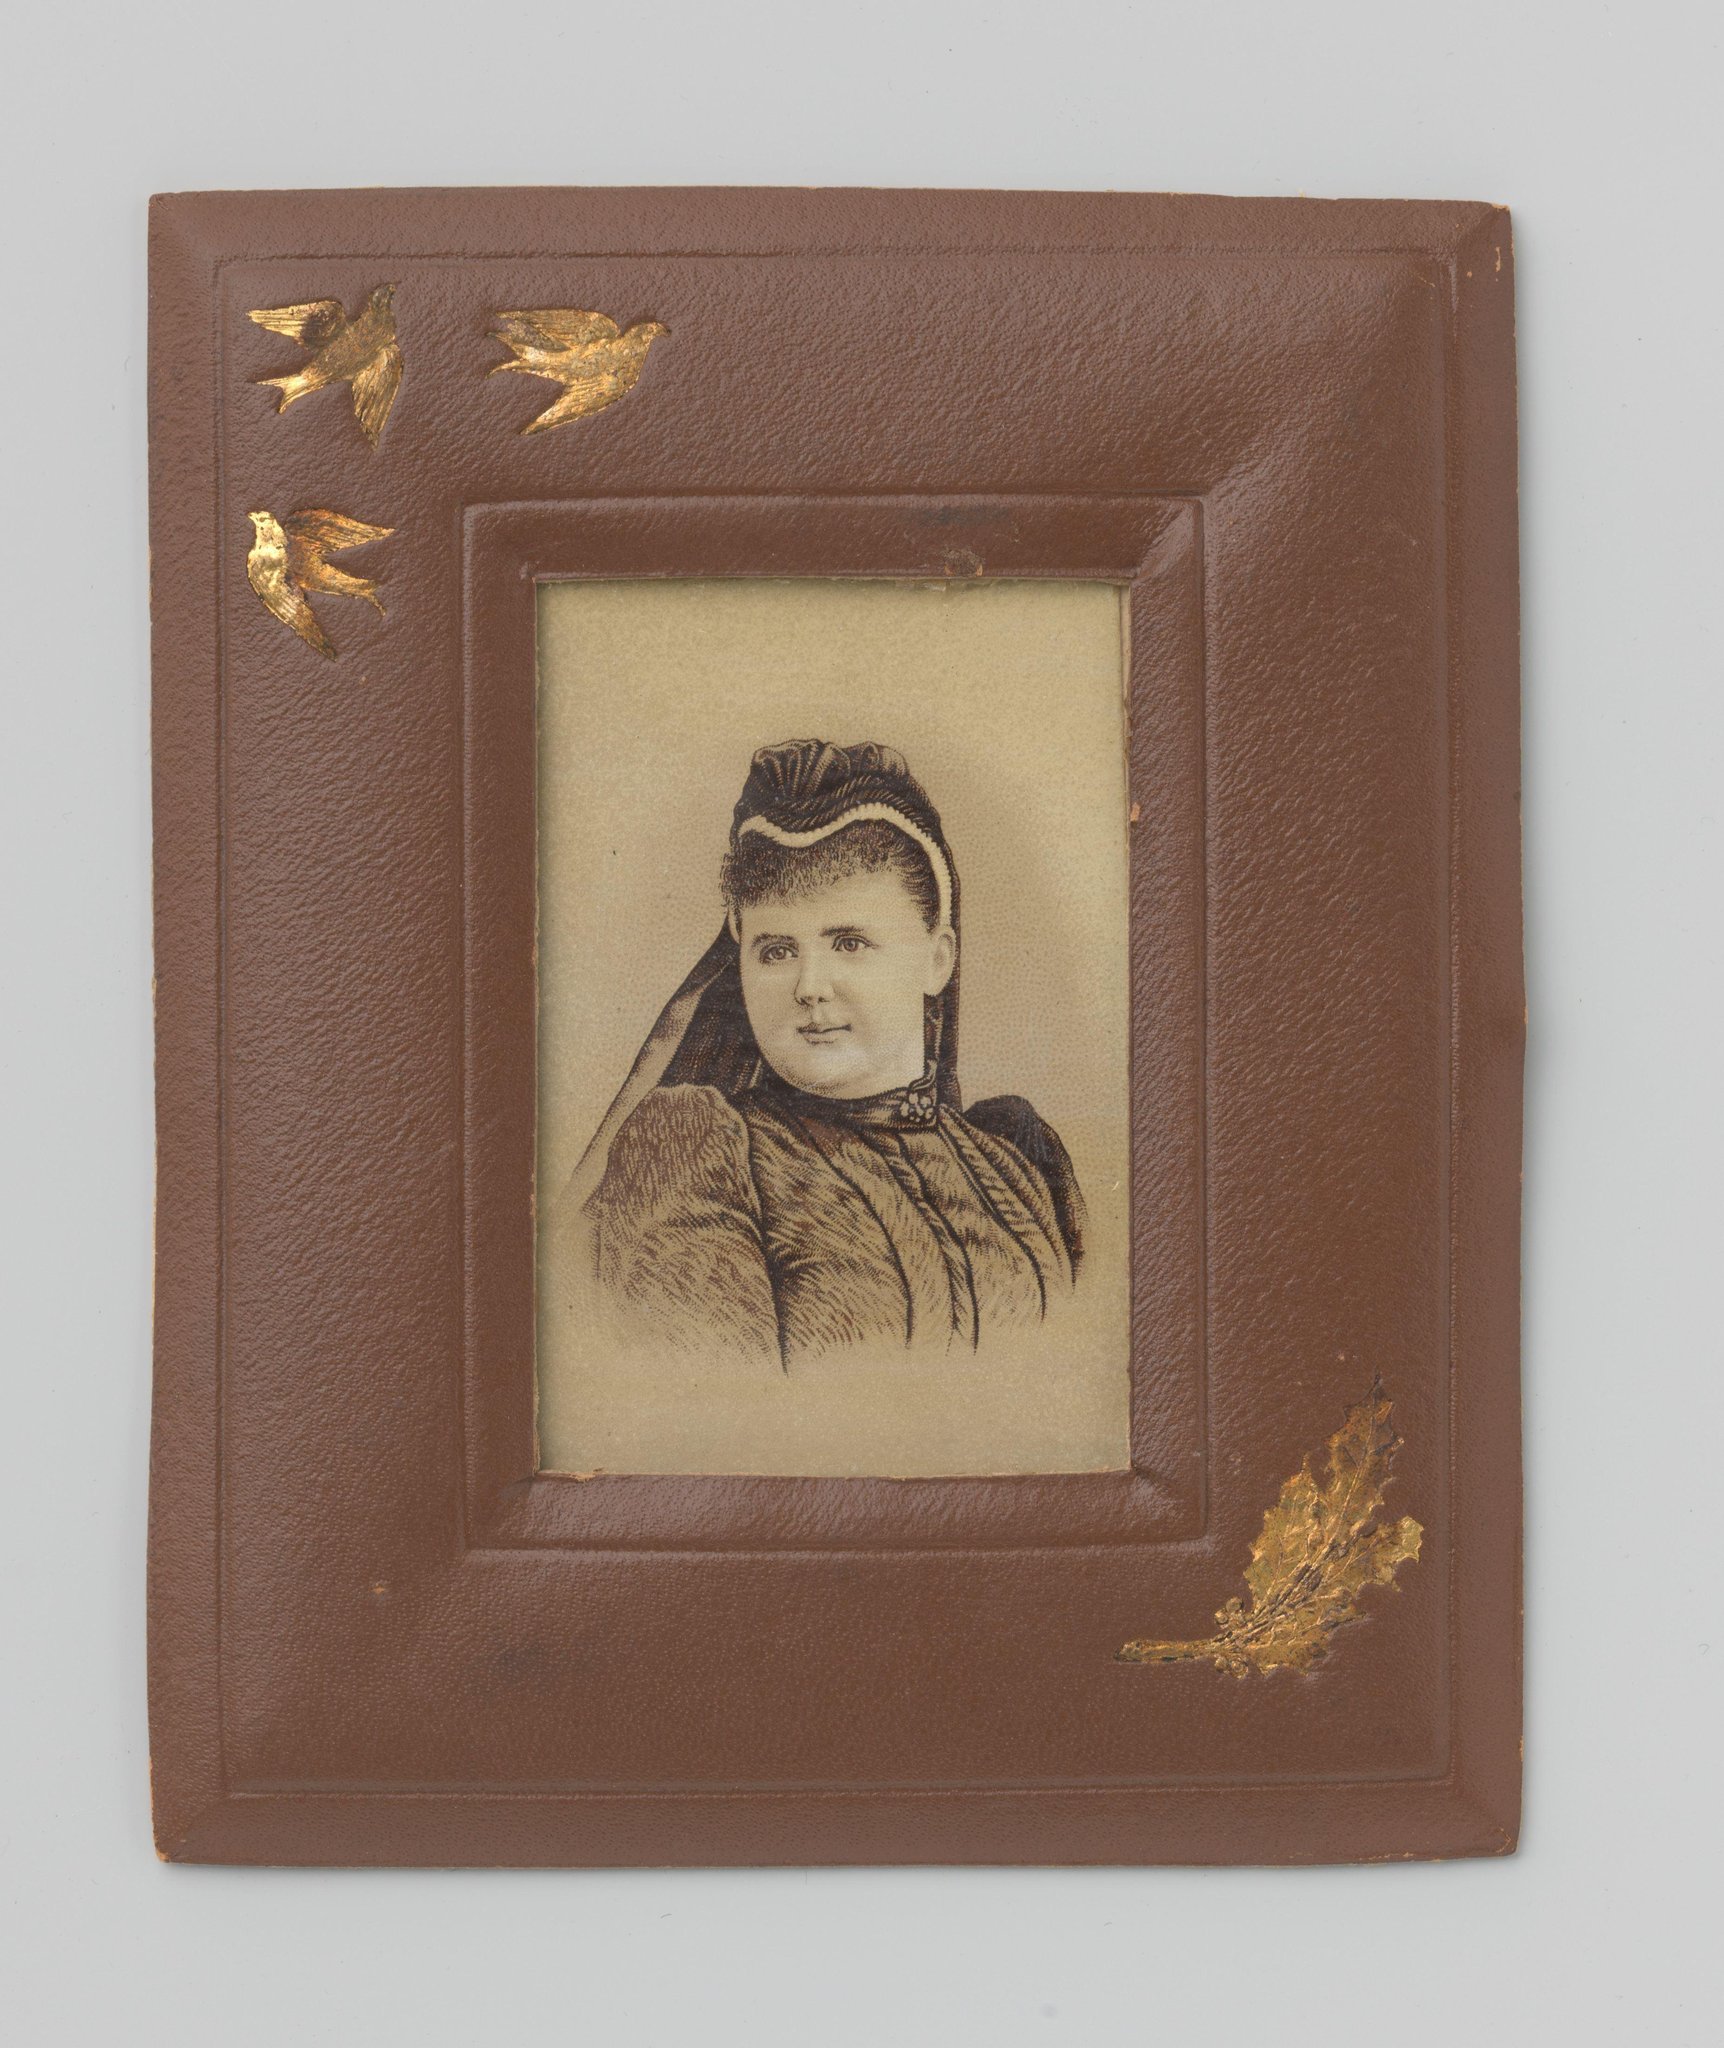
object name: print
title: Portret van prinses Emma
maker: Anonymous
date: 1880-1900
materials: glass, leather, paper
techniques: printing block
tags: the hague, emma (queen consort of the netherlands), adult woman, historical persons (portraits and scenes from the life) - bb - woman